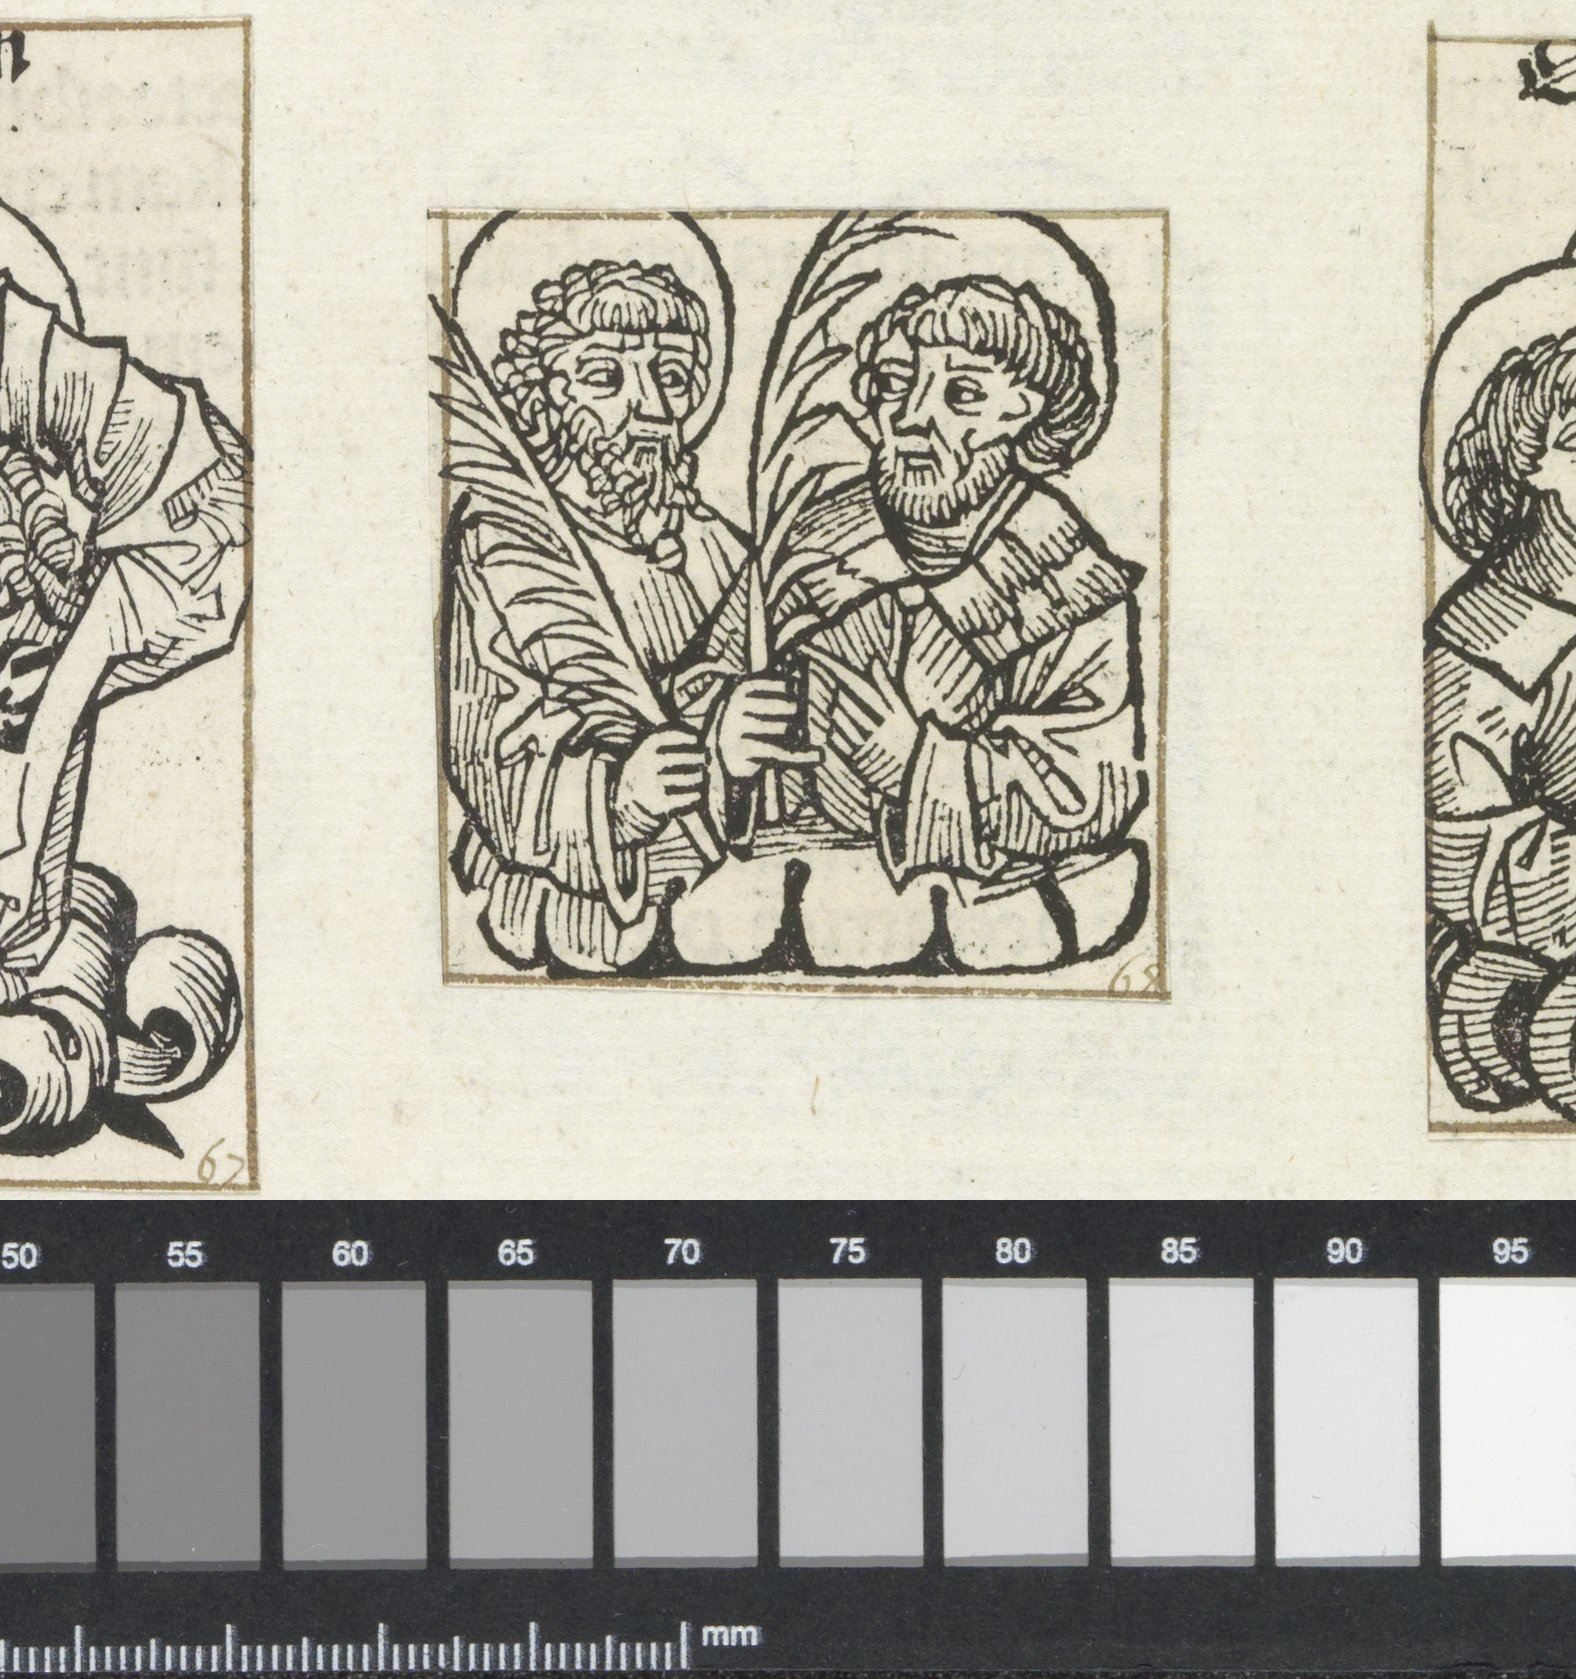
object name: book illustration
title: Felix en Fortunatus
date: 1493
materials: paper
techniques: letterpress printing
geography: nuremberg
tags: saints, martyr(s) (often with palm-branches)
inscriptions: inscription: ‘68’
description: De houtsnede wordt herhaaldelijk gebruikt als boekillustratie in de Liber Chronicarum (of Neurenbergkroniek) van Hartmann Schedel, verschenen in het Latijn en Duits in 1493. Zie de Latijnse uitgave, folio 125v.